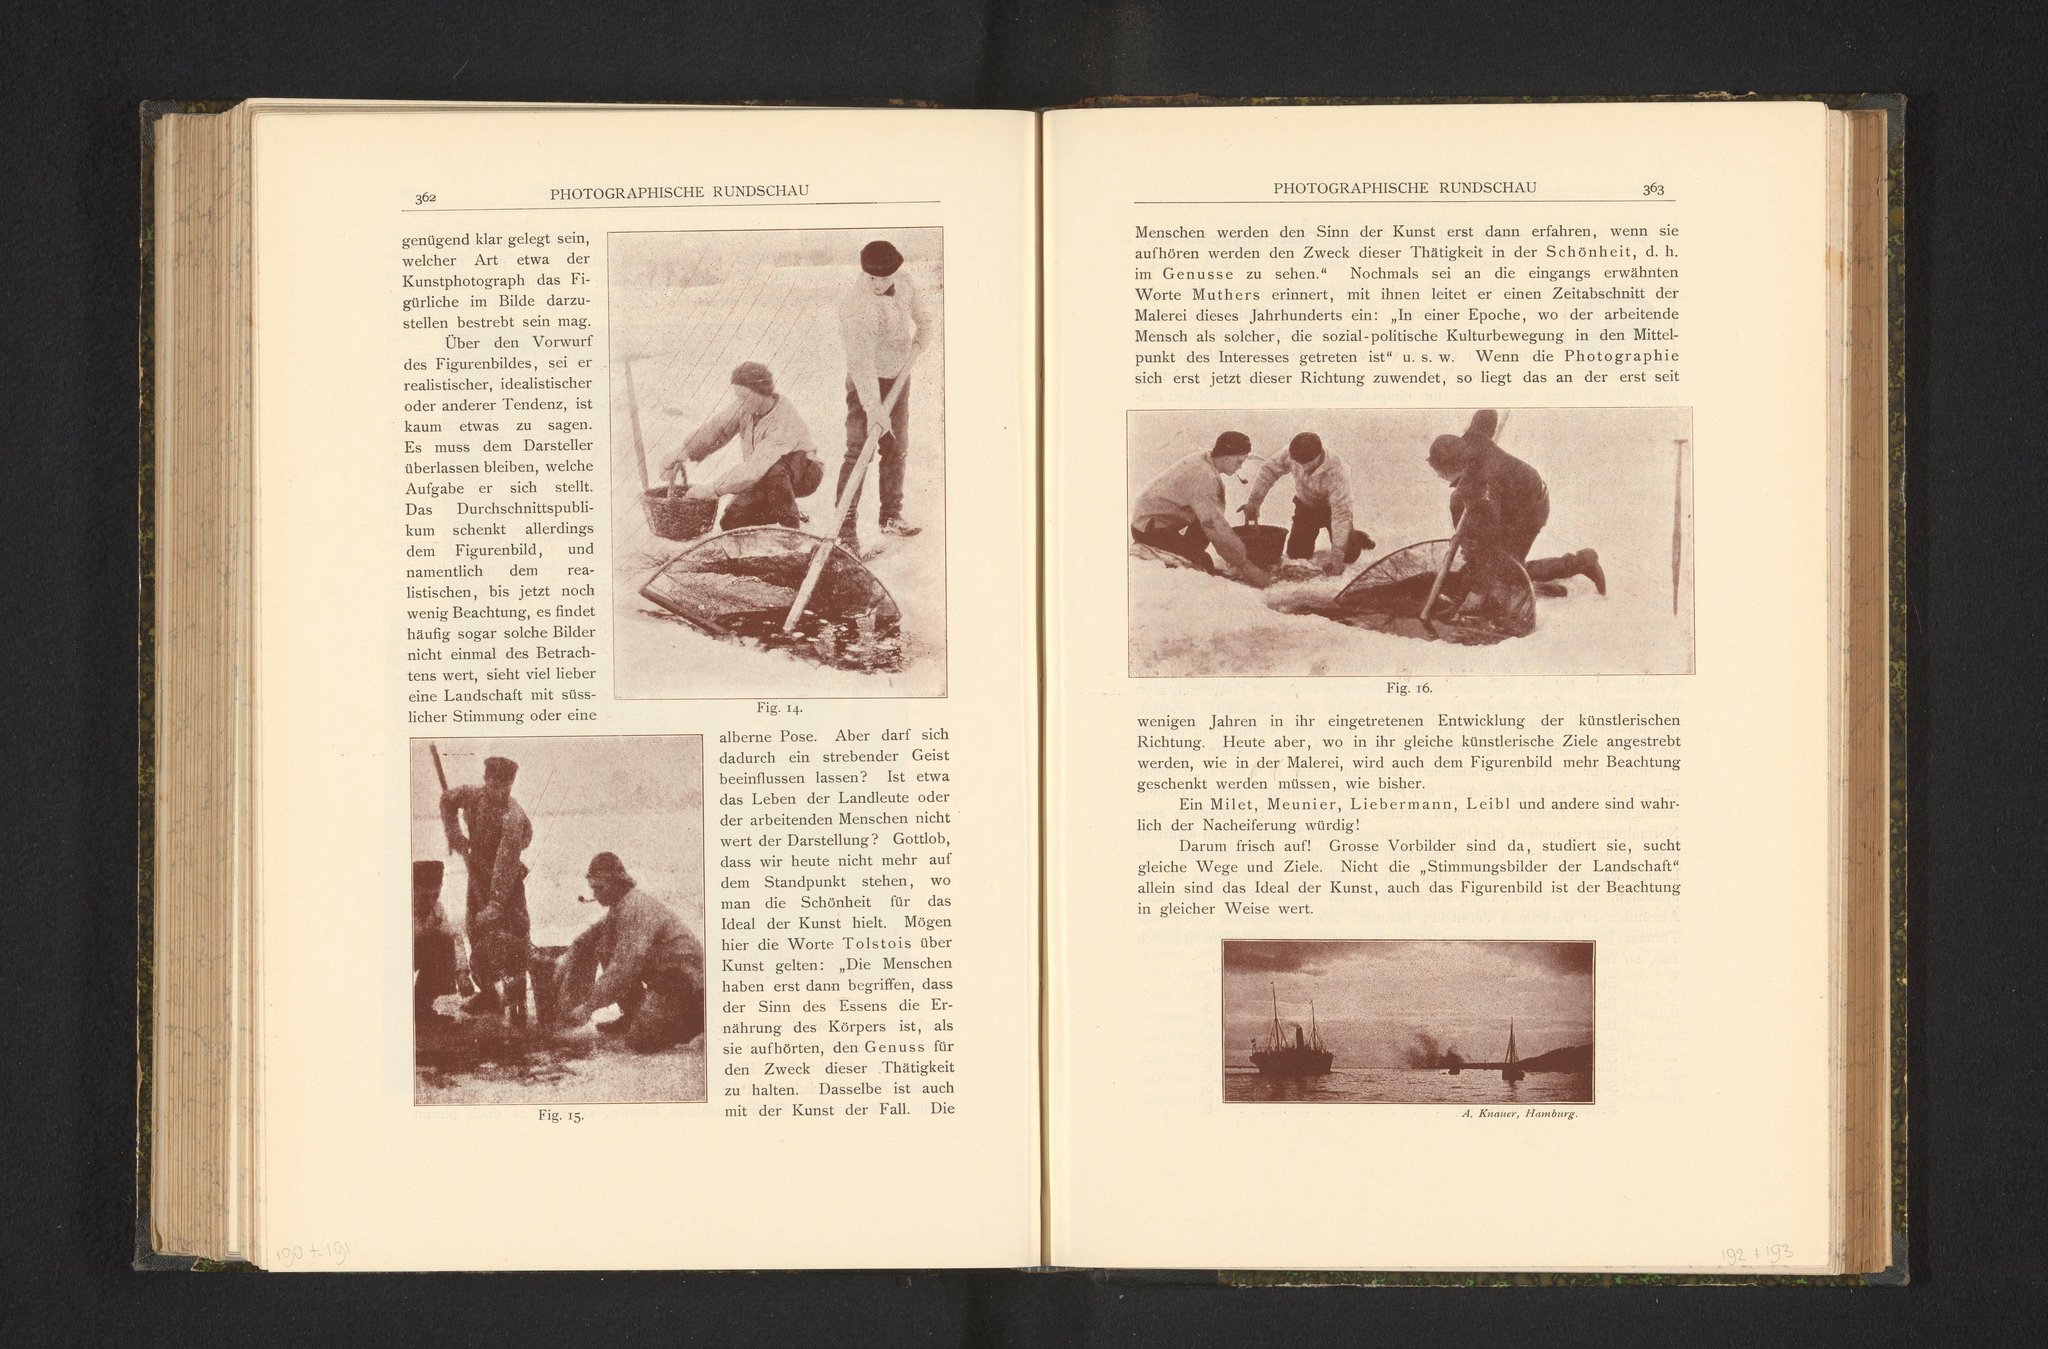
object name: page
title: Twee onbekende mannen die ijsvissen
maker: Anonymous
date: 1893-1898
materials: paper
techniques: autotype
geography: berlin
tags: snow, ice ~ state of water, fisherman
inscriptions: monogram: ‘MR/ &Co’